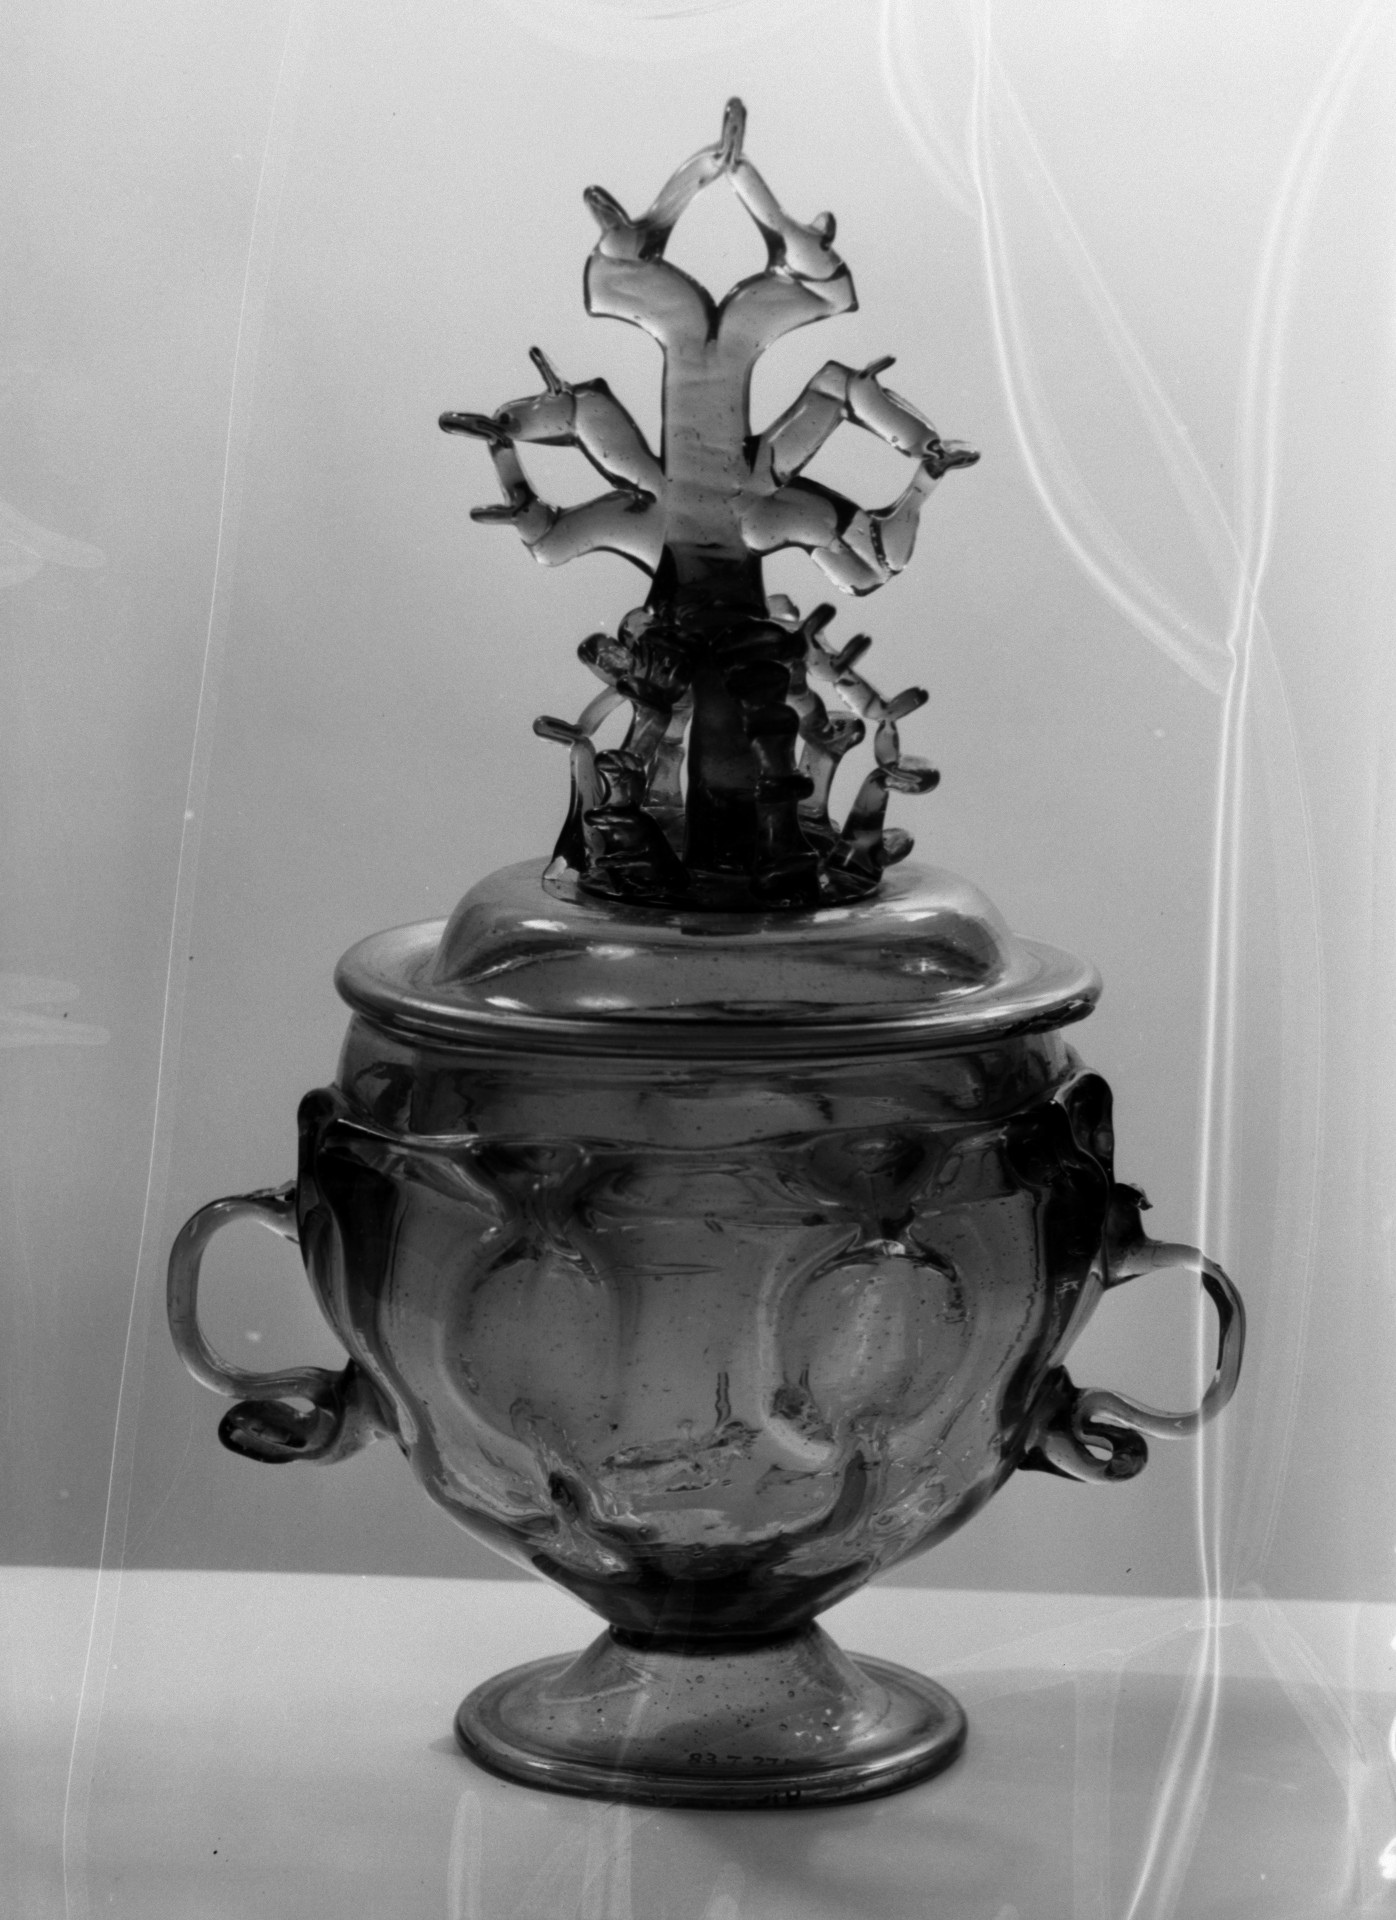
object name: bowl with cover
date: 1701-1900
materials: glass